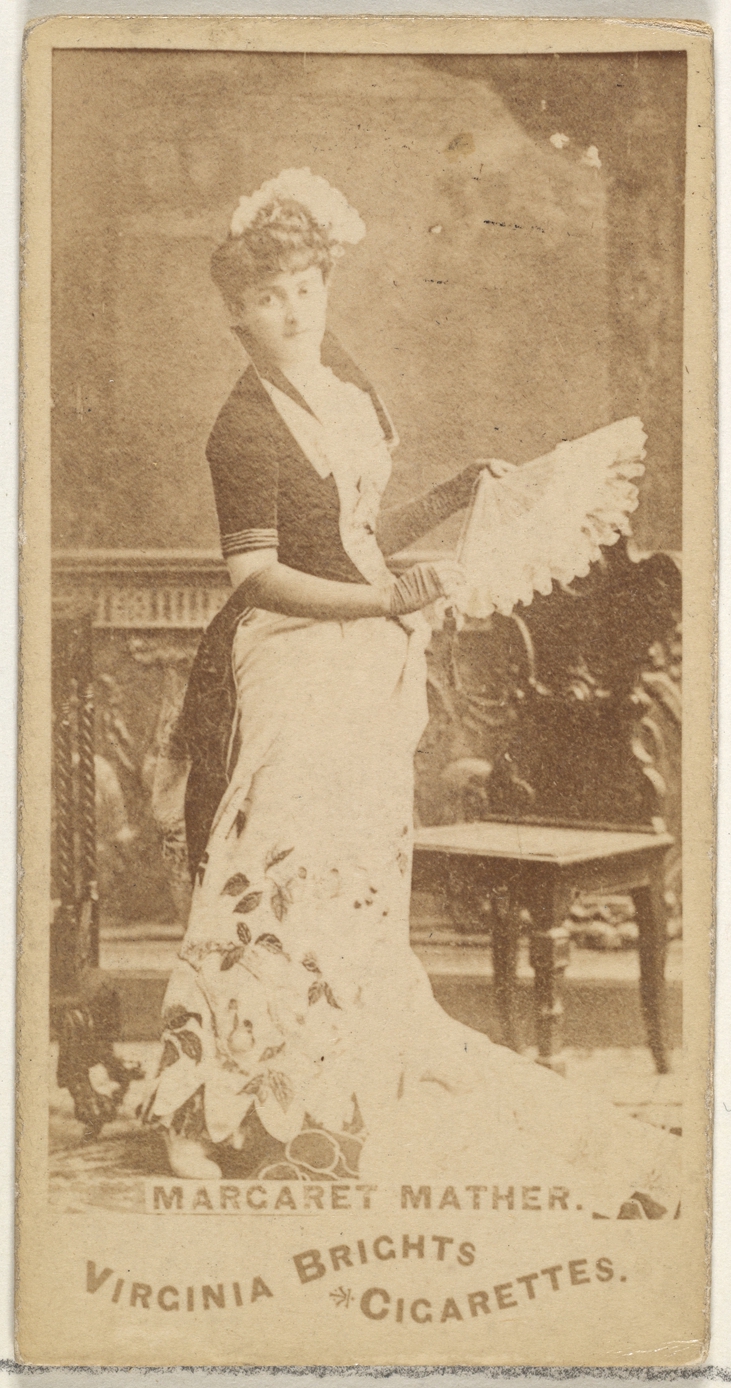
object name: photograph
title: Margaret Mather, from the Actors and Actresses series (N45, Type 1) for Virginia Brights Cigarettes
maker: allen & ginter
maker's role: publisher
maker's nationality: american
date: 1888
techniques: albumen silver print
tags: portraits,women,actresses